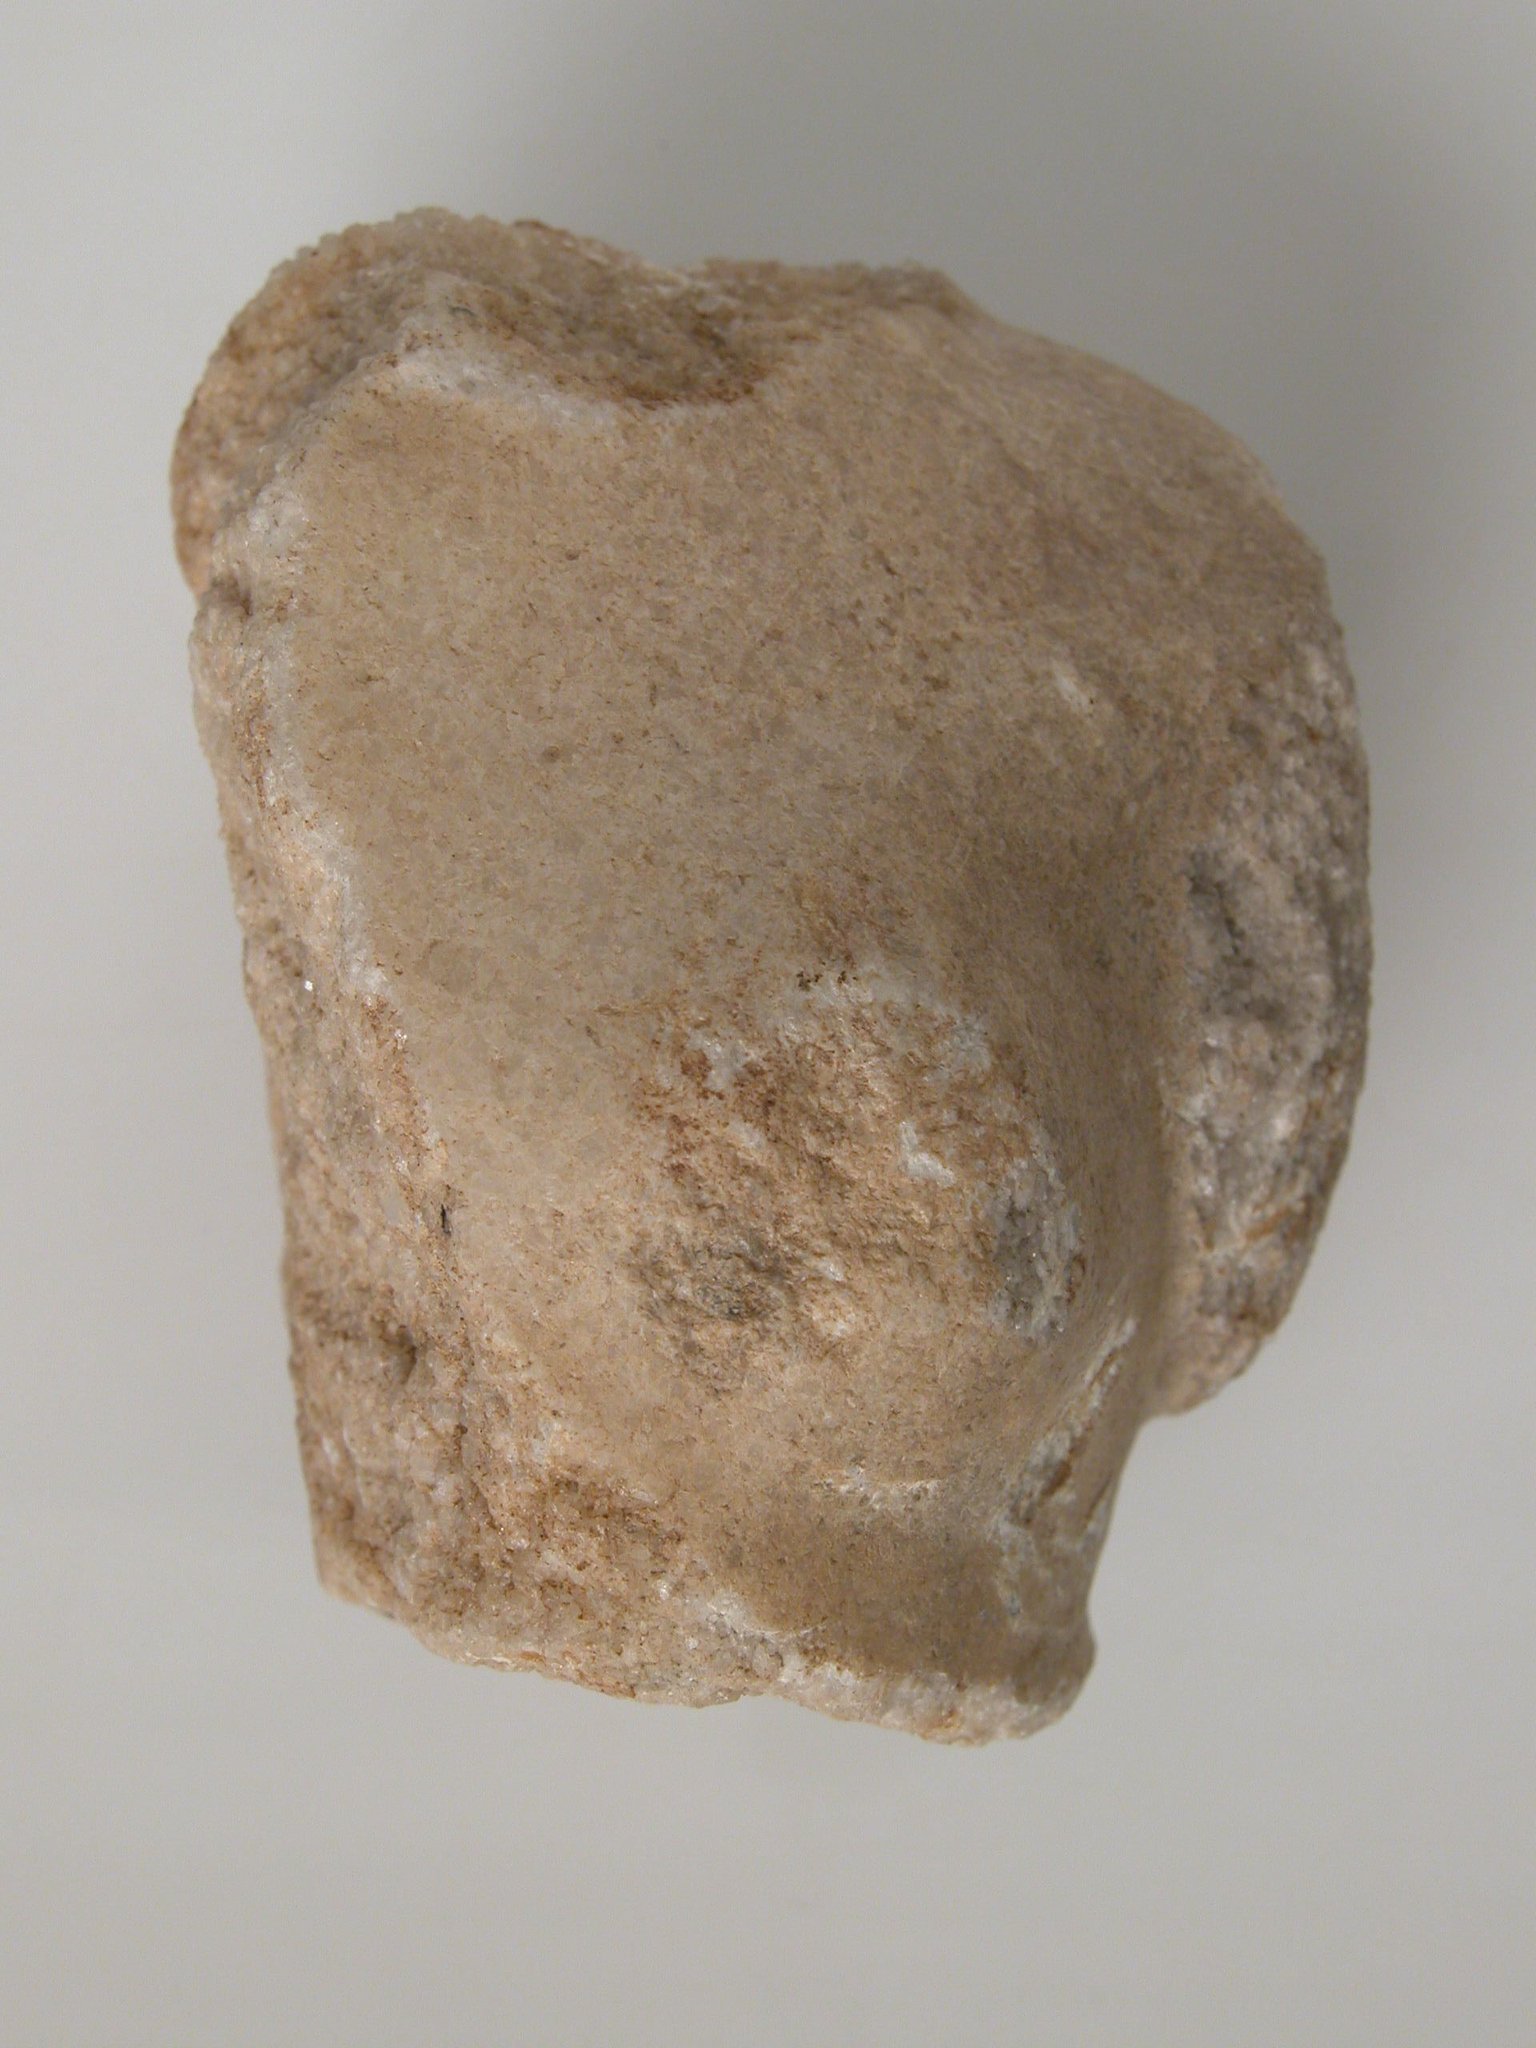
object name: stone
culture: coptic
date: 301-700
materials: stone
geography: egypt